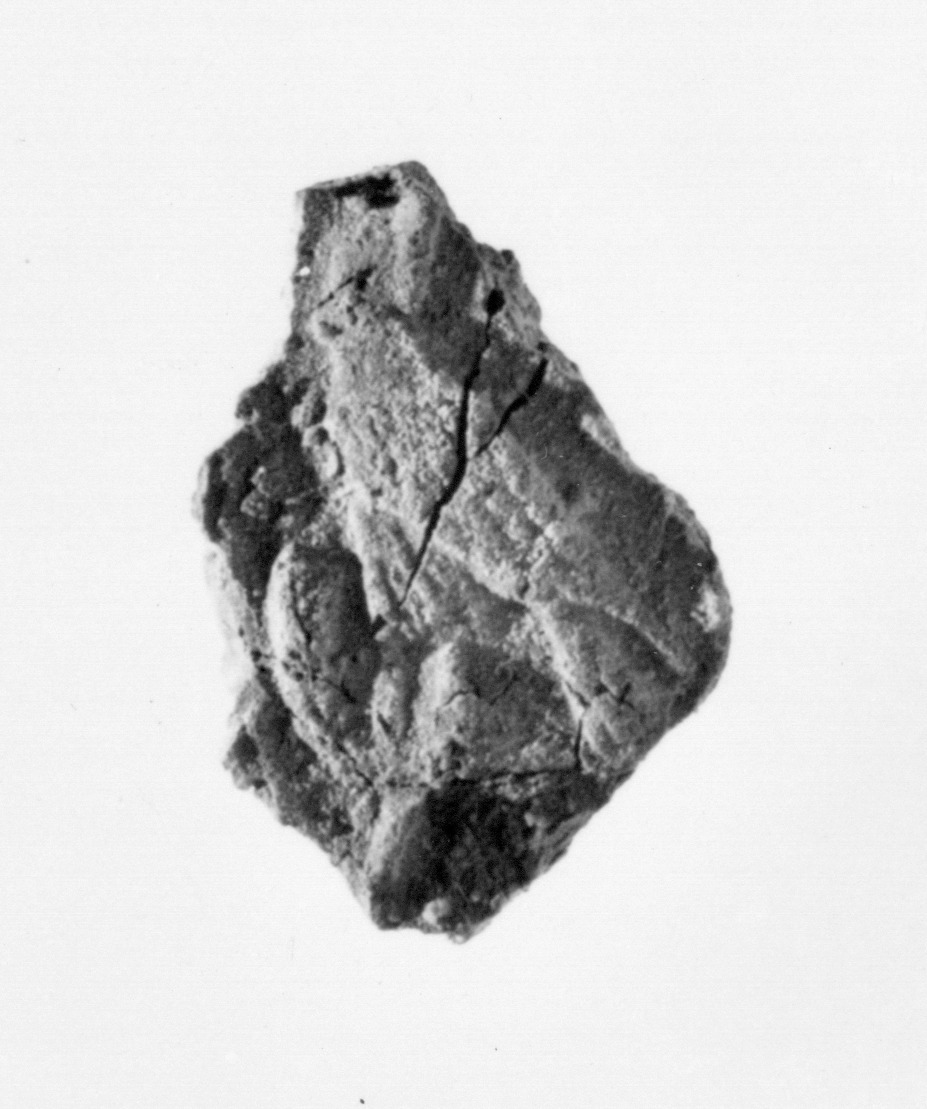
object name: sealing, horus, falcon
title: Document Sealing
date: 1390-1352 BCE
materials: mud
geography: egypt